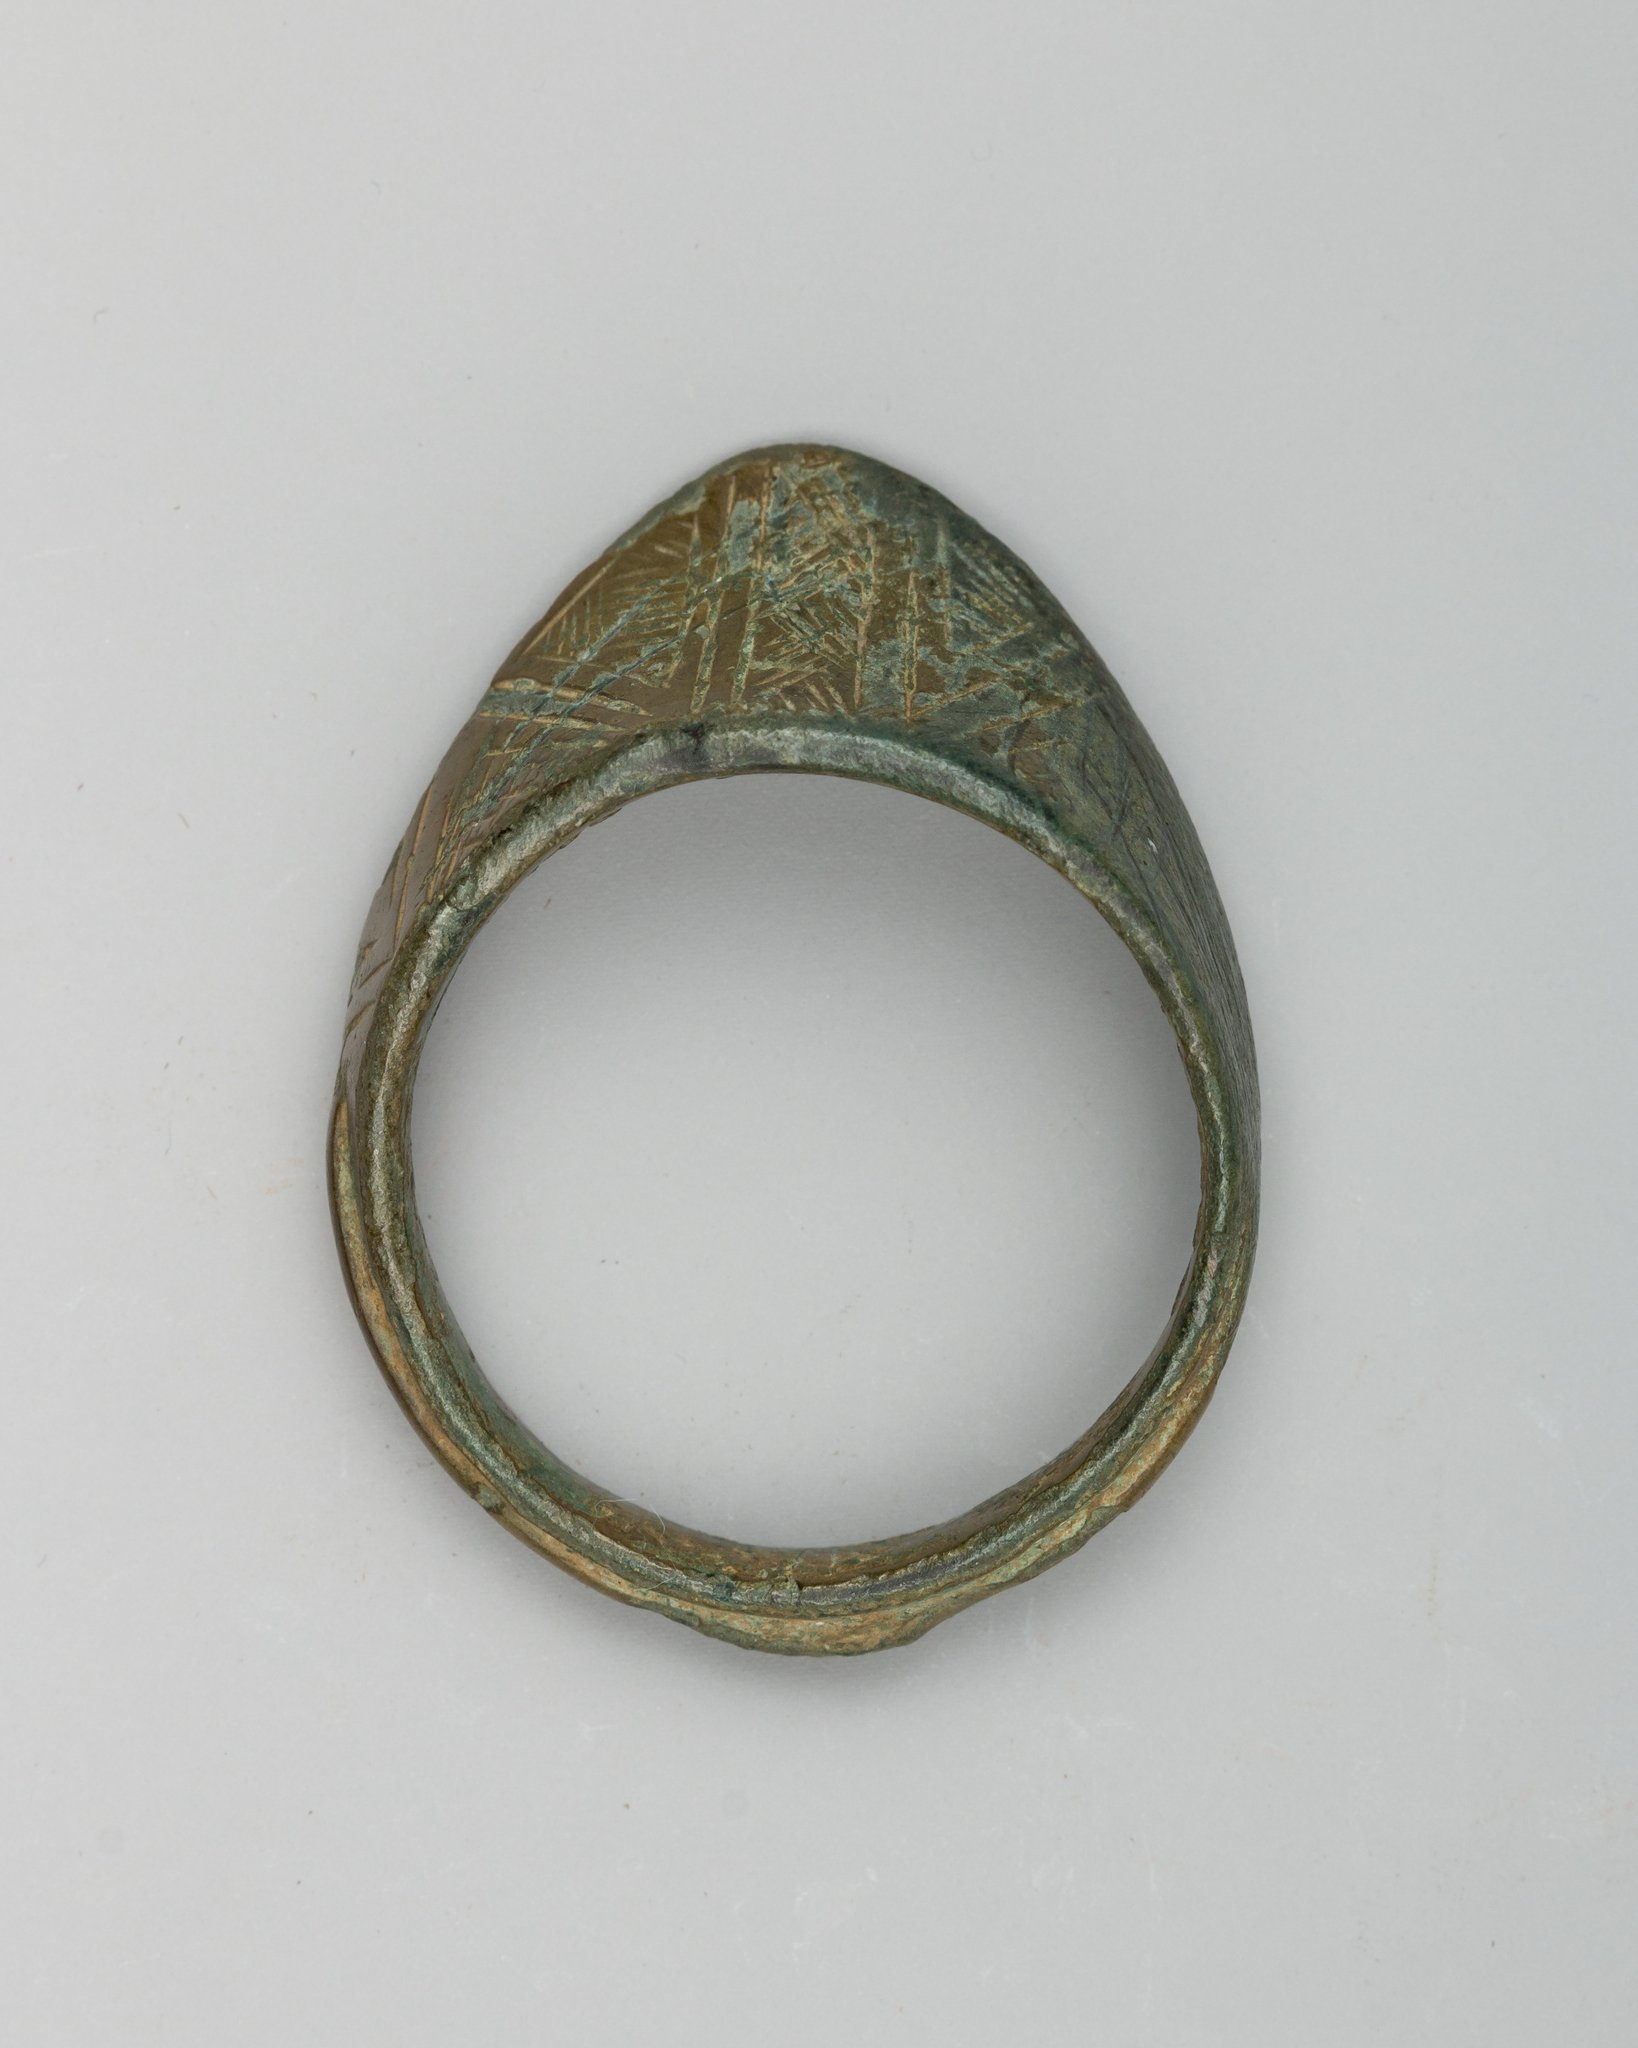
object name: archer's ring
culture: turkish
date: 1501-1700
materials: bronze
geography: ottoman empire